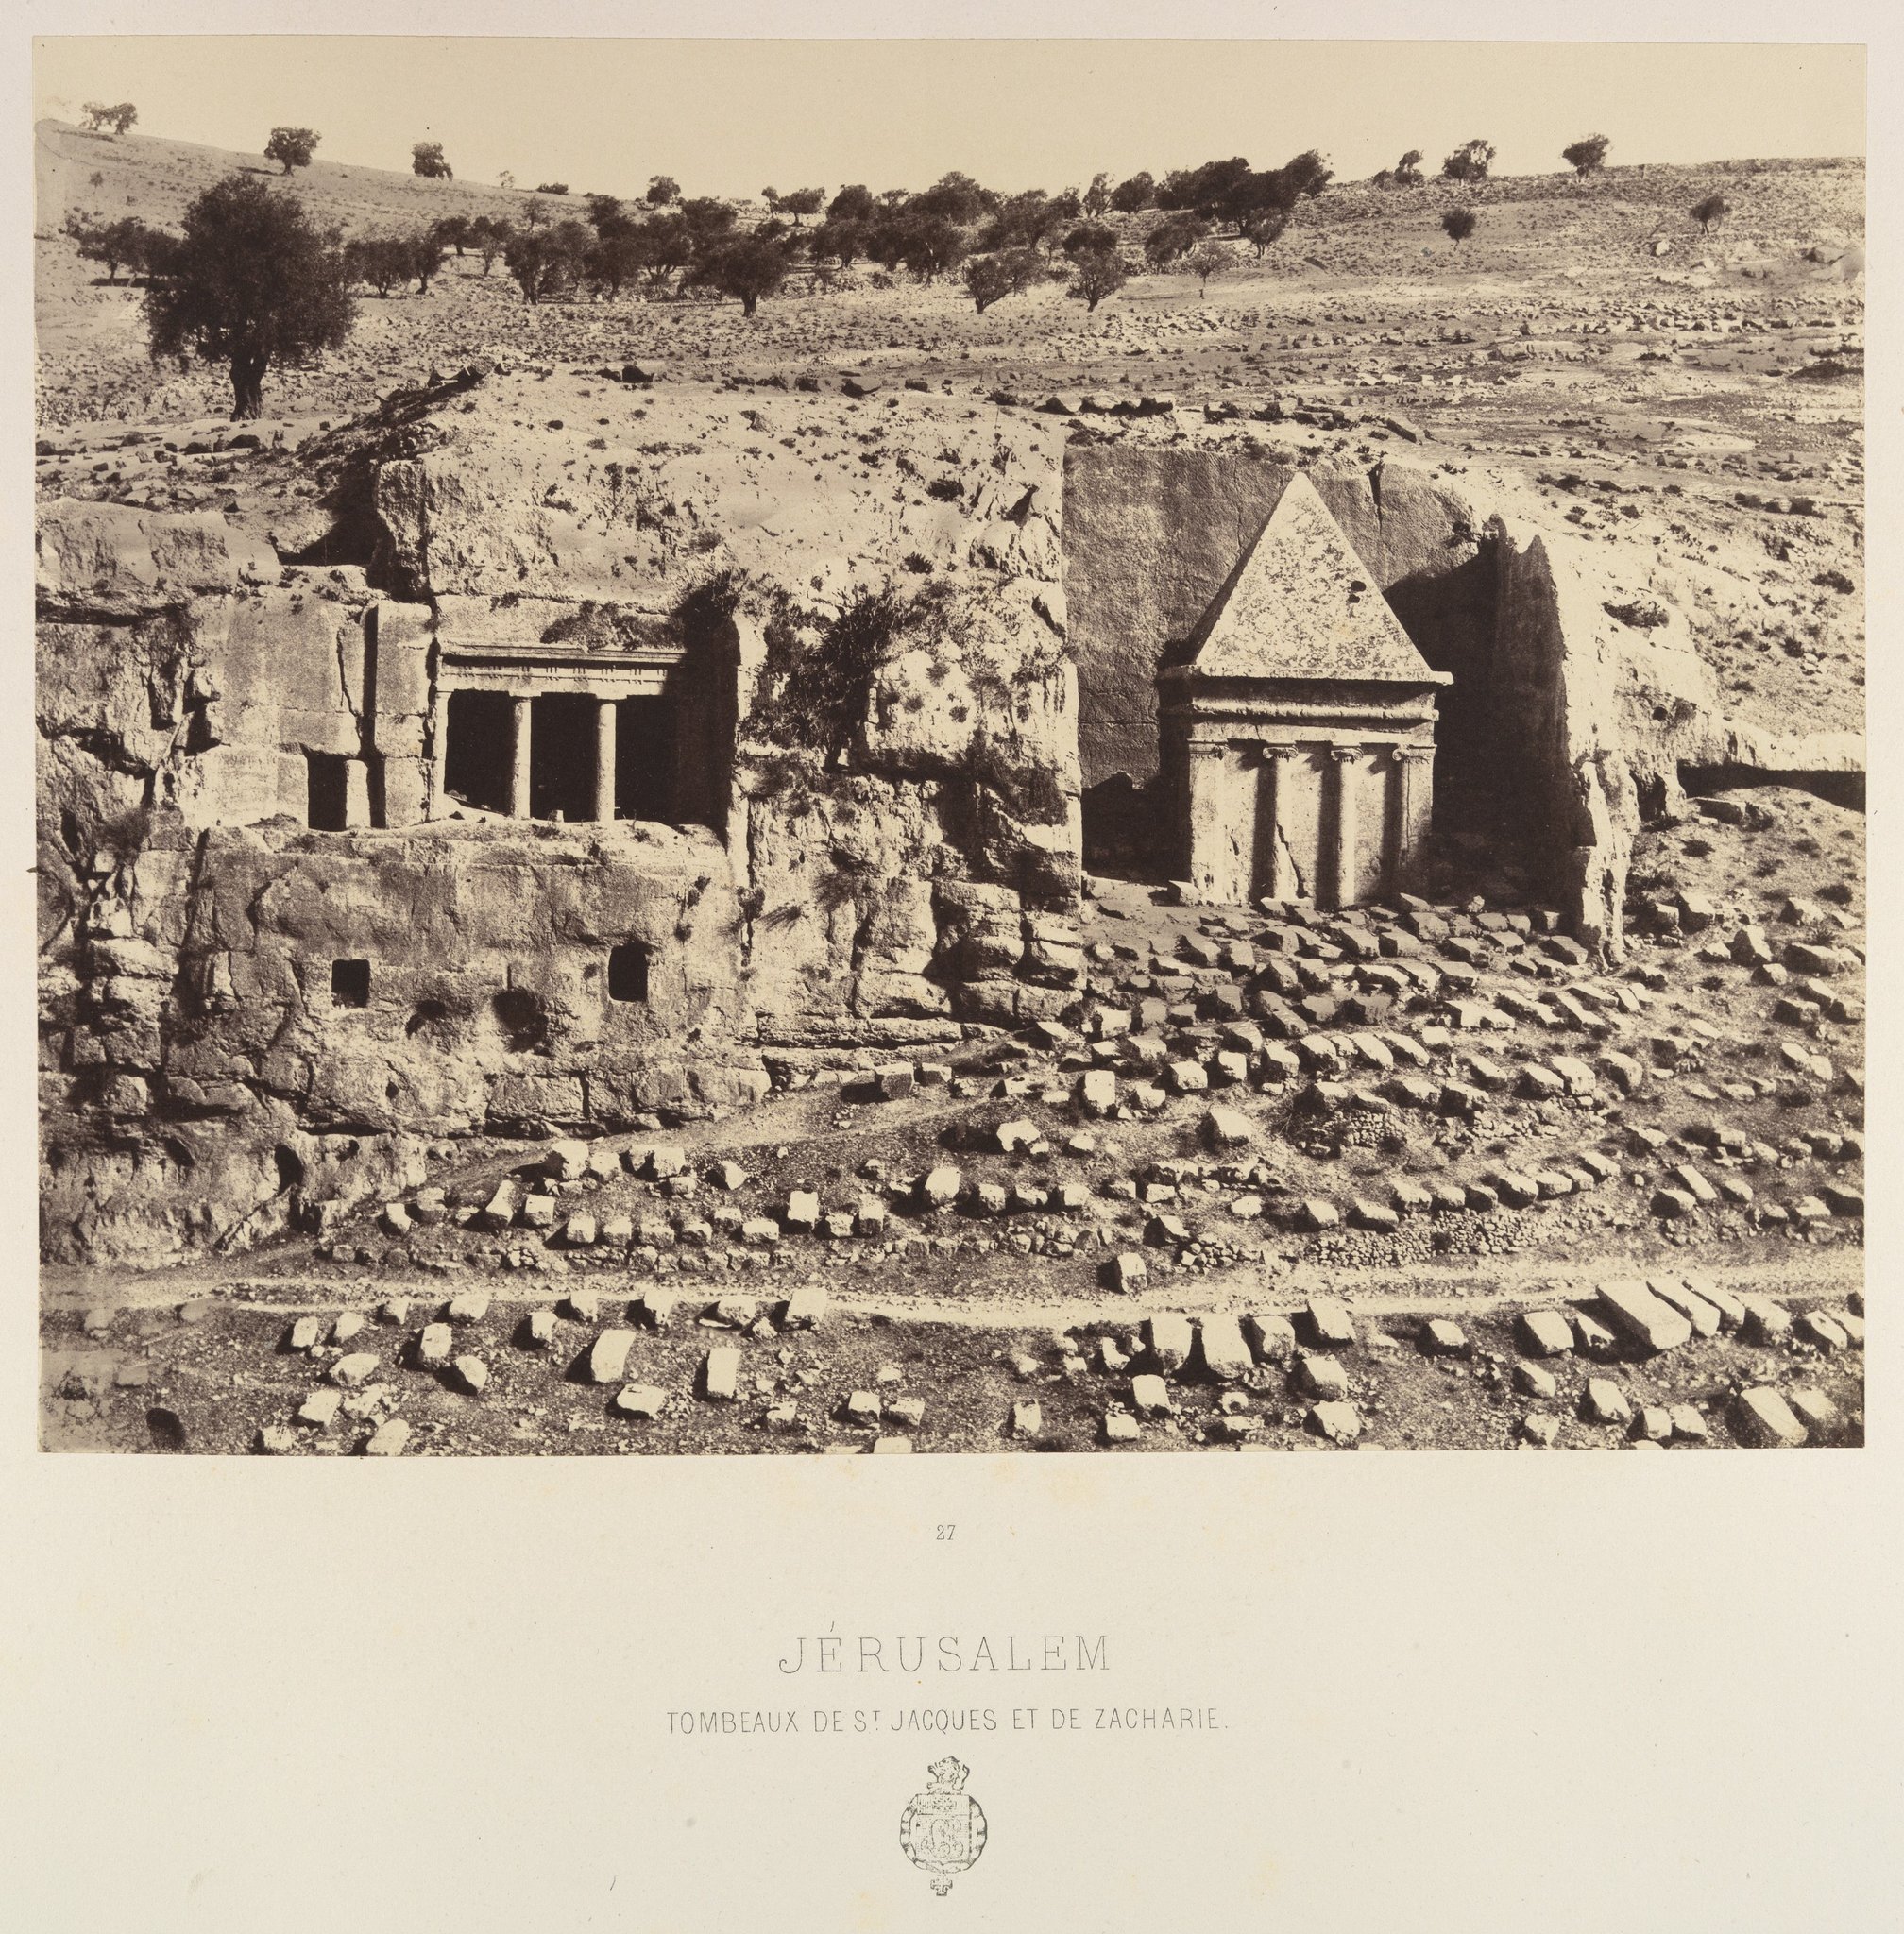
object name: photograph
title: Jérusalem. Tombeaux de St Jacques et de Zacharie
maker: louis de clercq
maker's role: artist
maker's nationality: french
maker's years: 1837-1901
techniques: albumen silver print, paper negative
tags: architecture,tombs,ruins